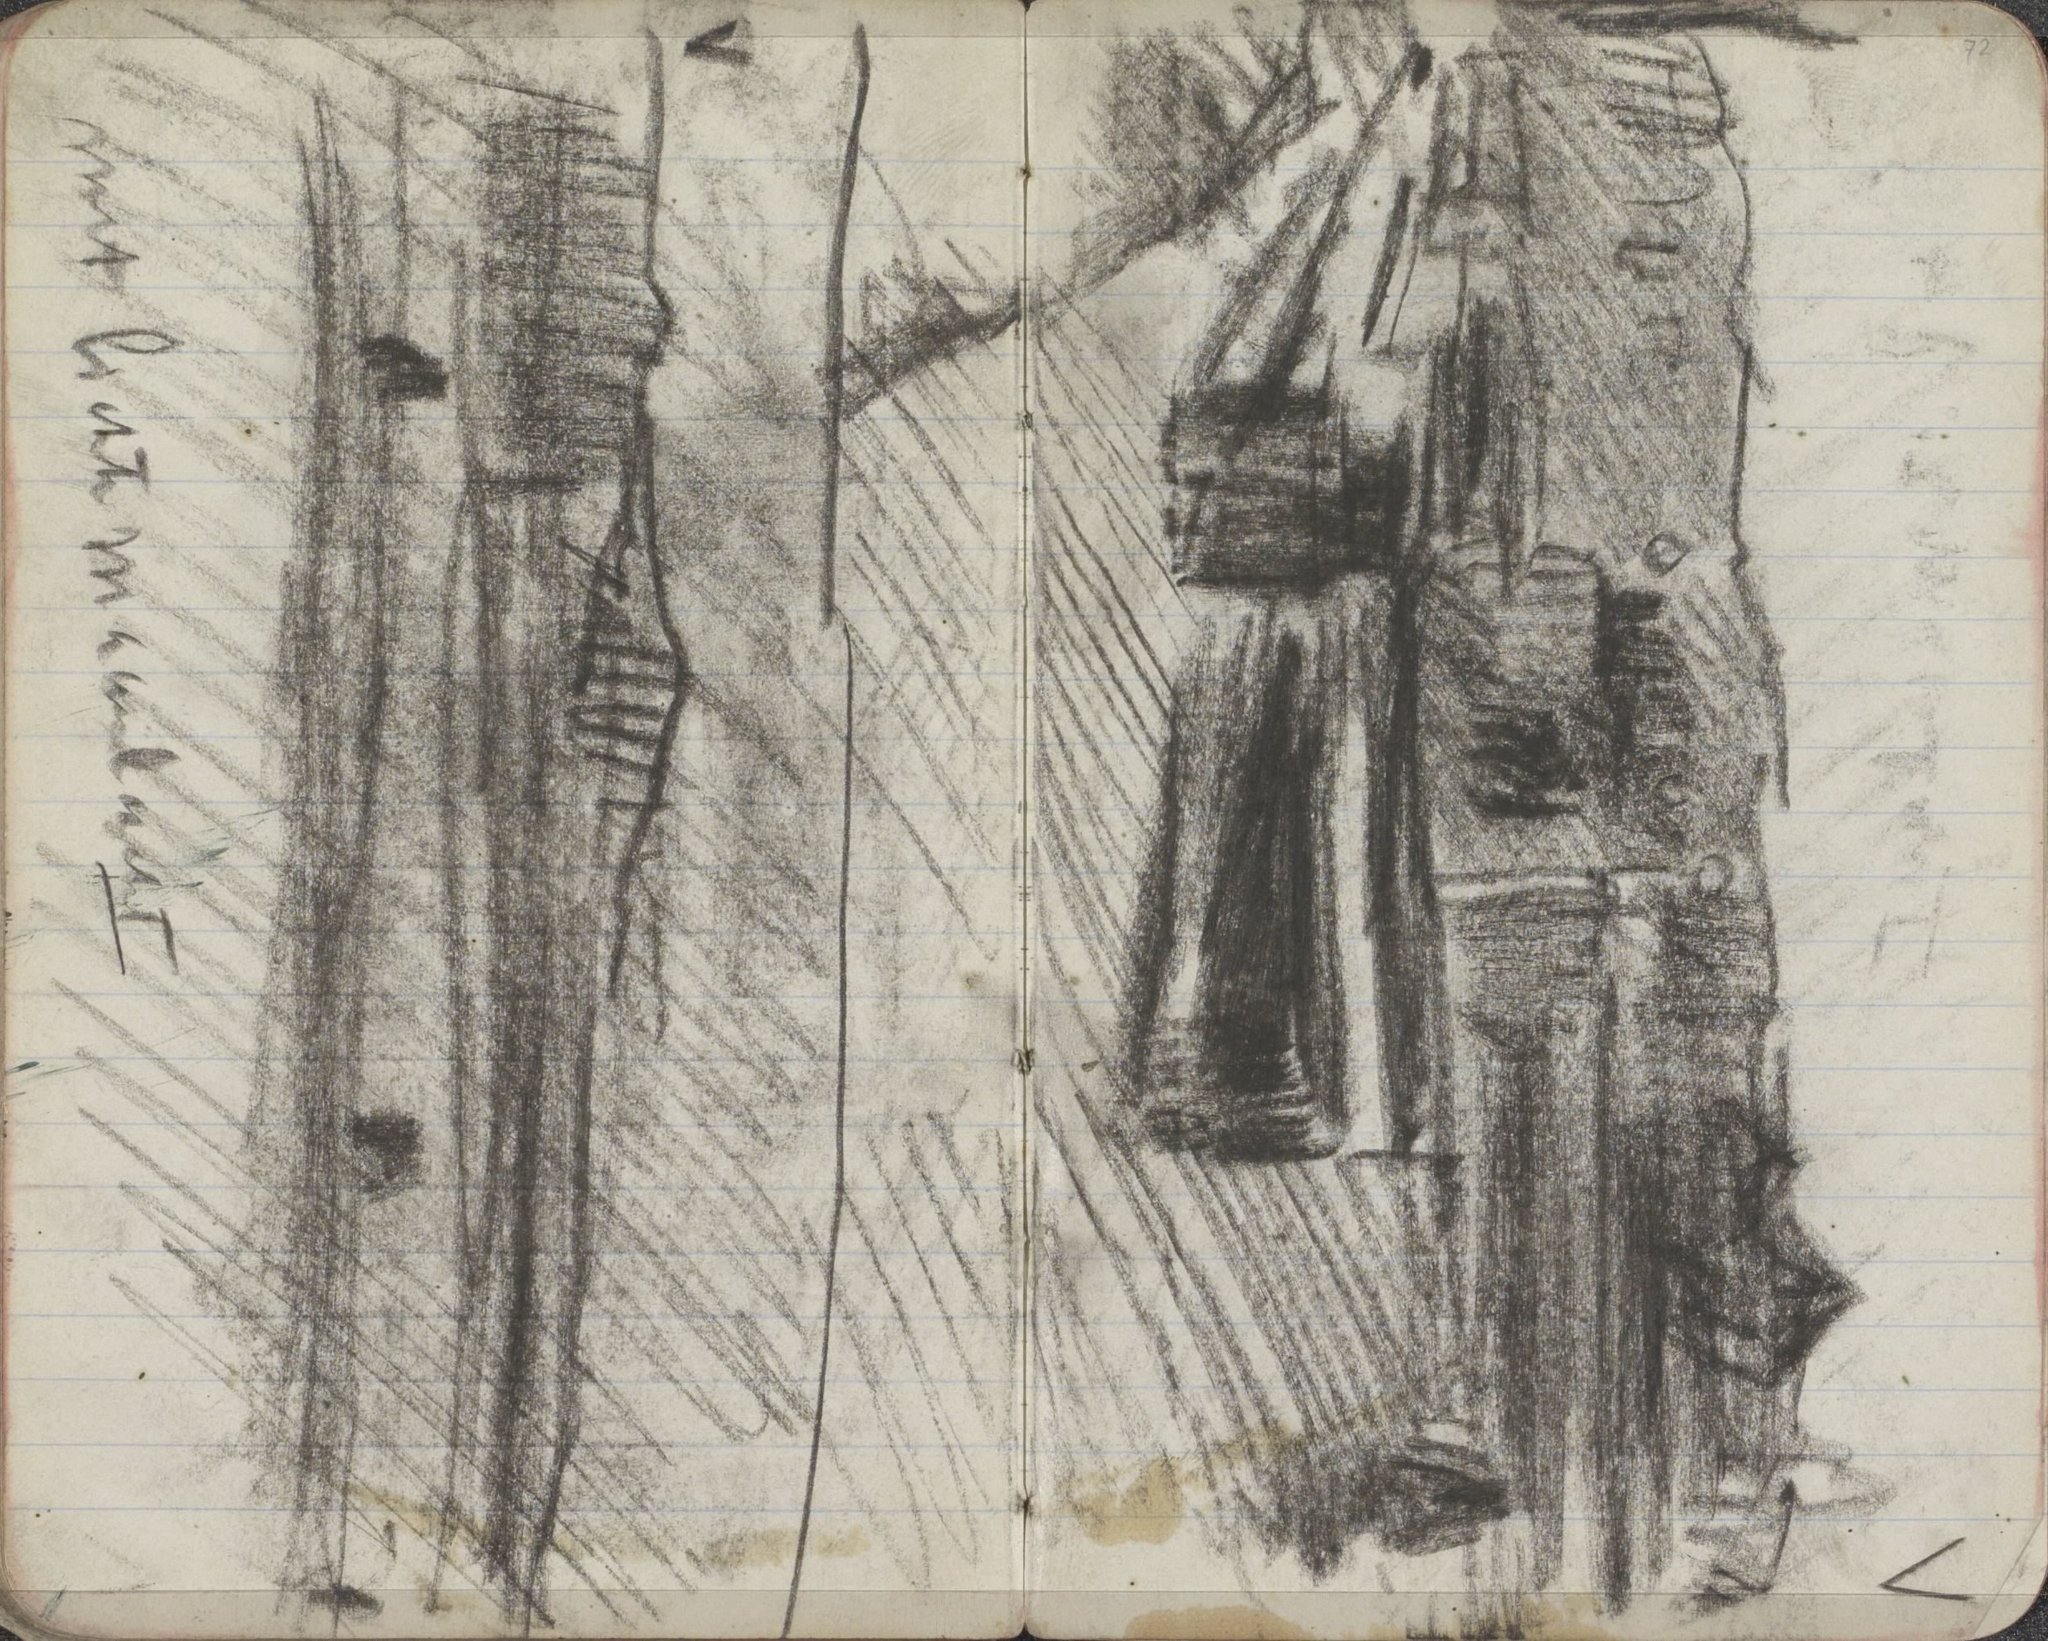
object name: sketchbook leaf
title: Twee gezichten in Amsterdam, mogelijk Bickerseiland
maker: george hendrik breitner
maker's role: draughtsman, painter, print maker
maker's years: 1857-1923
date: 1892-1900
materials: chalk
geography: amsterdam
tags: ships (in general), canals, waters (in city), civic architecture; edifices; dwellings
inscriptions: annotation: ‘met lichte maanlucht’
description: Pagina 71 en pagina 72 uit een schetsboek met 38 bladen.